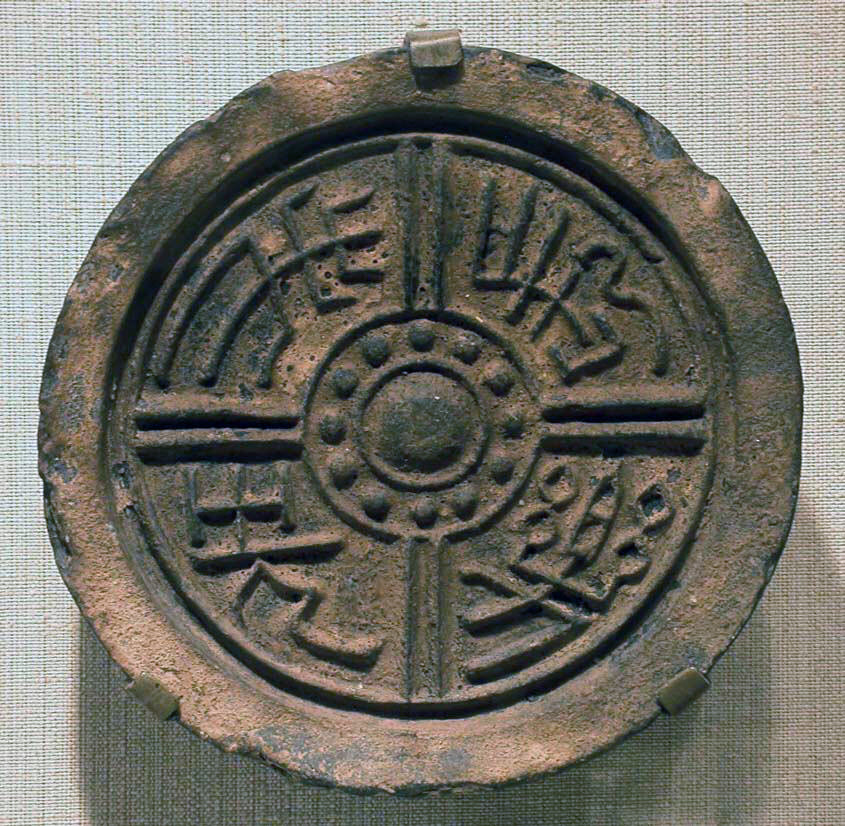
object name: tile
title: Roof-Tile End with Auspicious Inscription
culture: chinese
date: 206 BCE-9 CE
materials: earthenware